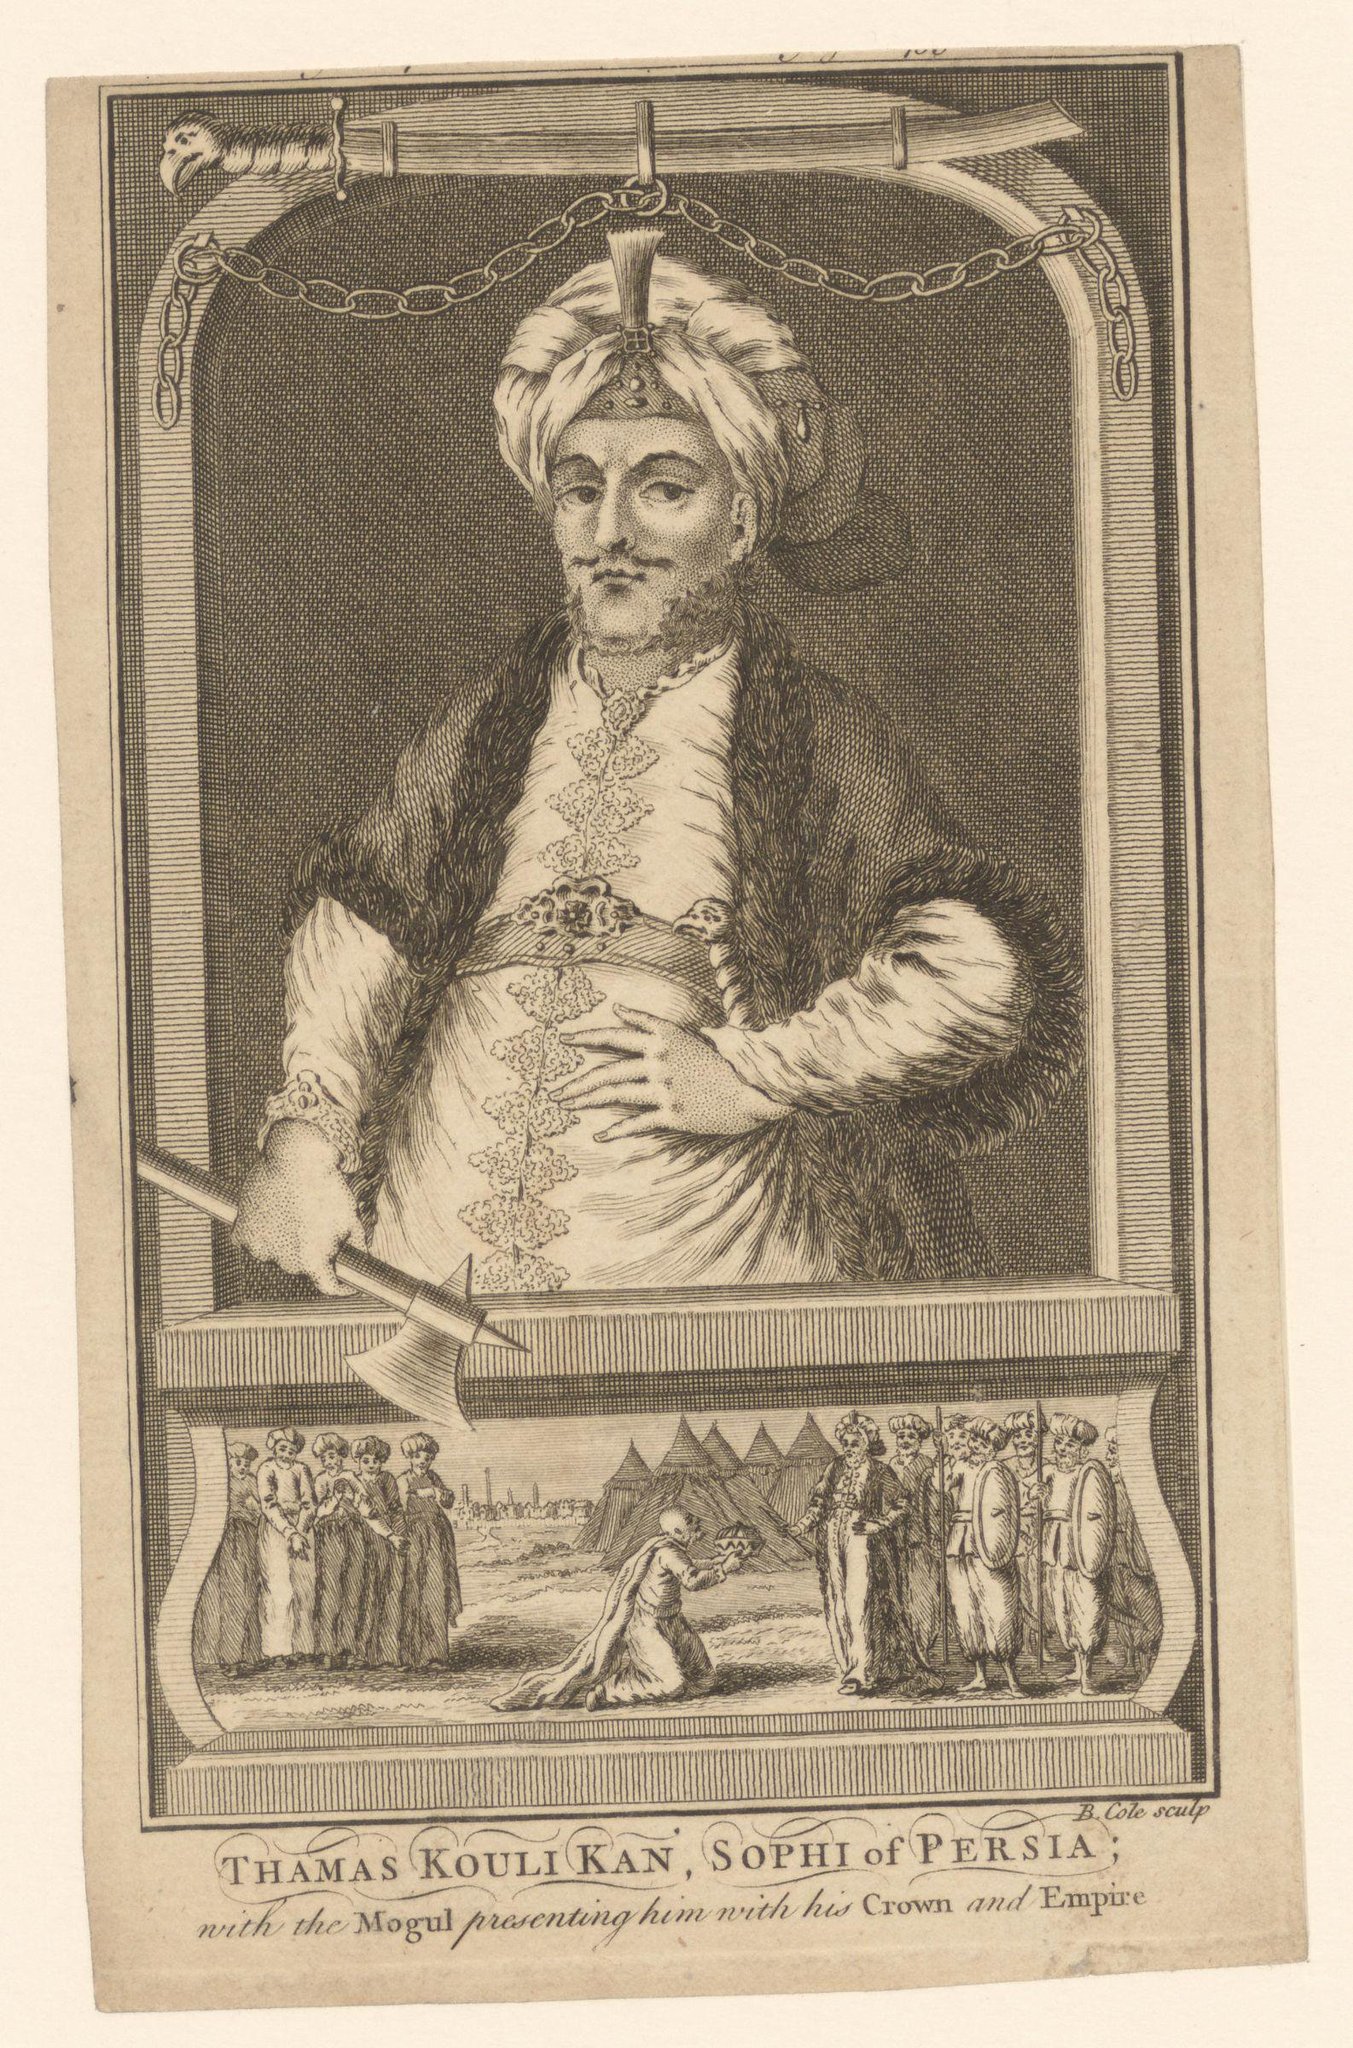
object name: print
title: Thomas Kouli Kan, Sophi of Persia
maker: benjamin cole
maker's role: print maker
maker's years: 1667-1729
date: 1722-1729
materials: paper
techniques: etching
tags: historical persons, ruler, sovereign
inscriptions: collector's mark: Lugt 2228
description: Onderaan biedt de heerser van het Mogolrijk, Nadir Sjah zijn kroon en heerschappij aan. Tekst in het Engels in de ondermarge.